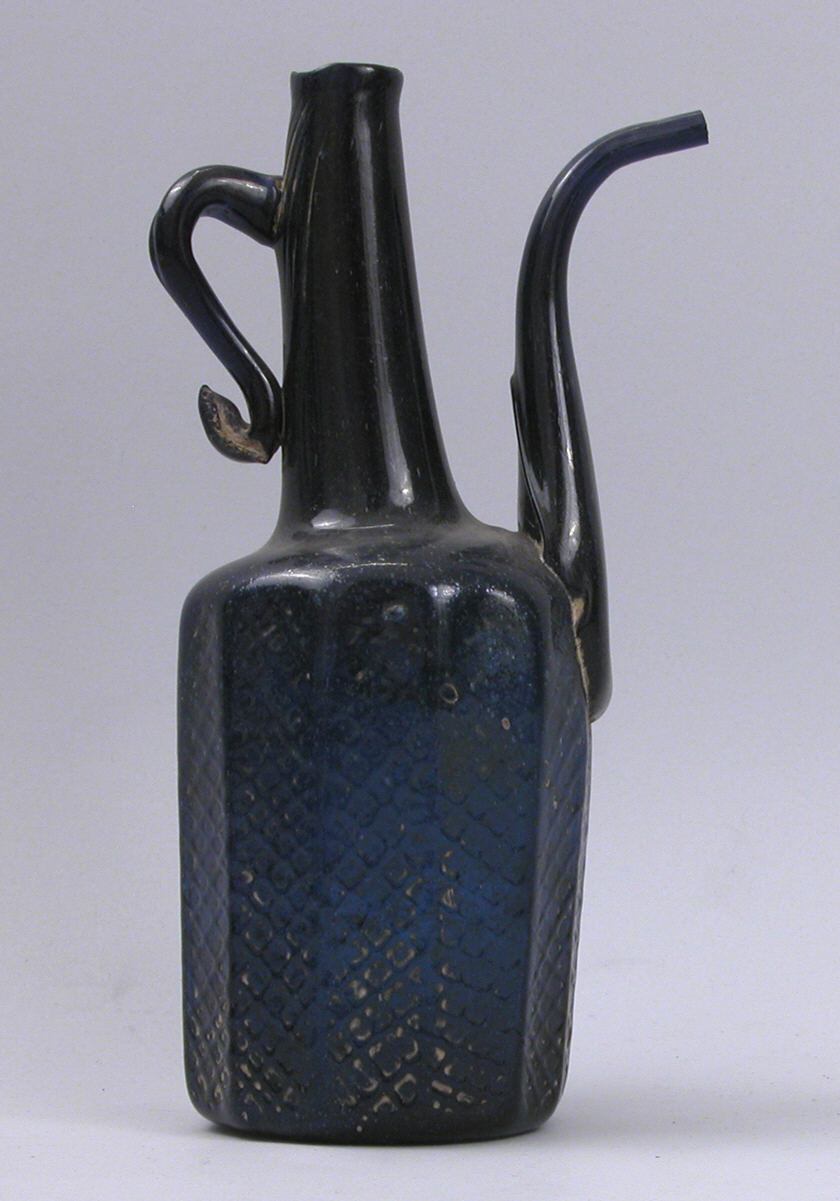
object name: ewer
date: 1701-1900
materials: glass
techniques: glassblowing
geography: iran